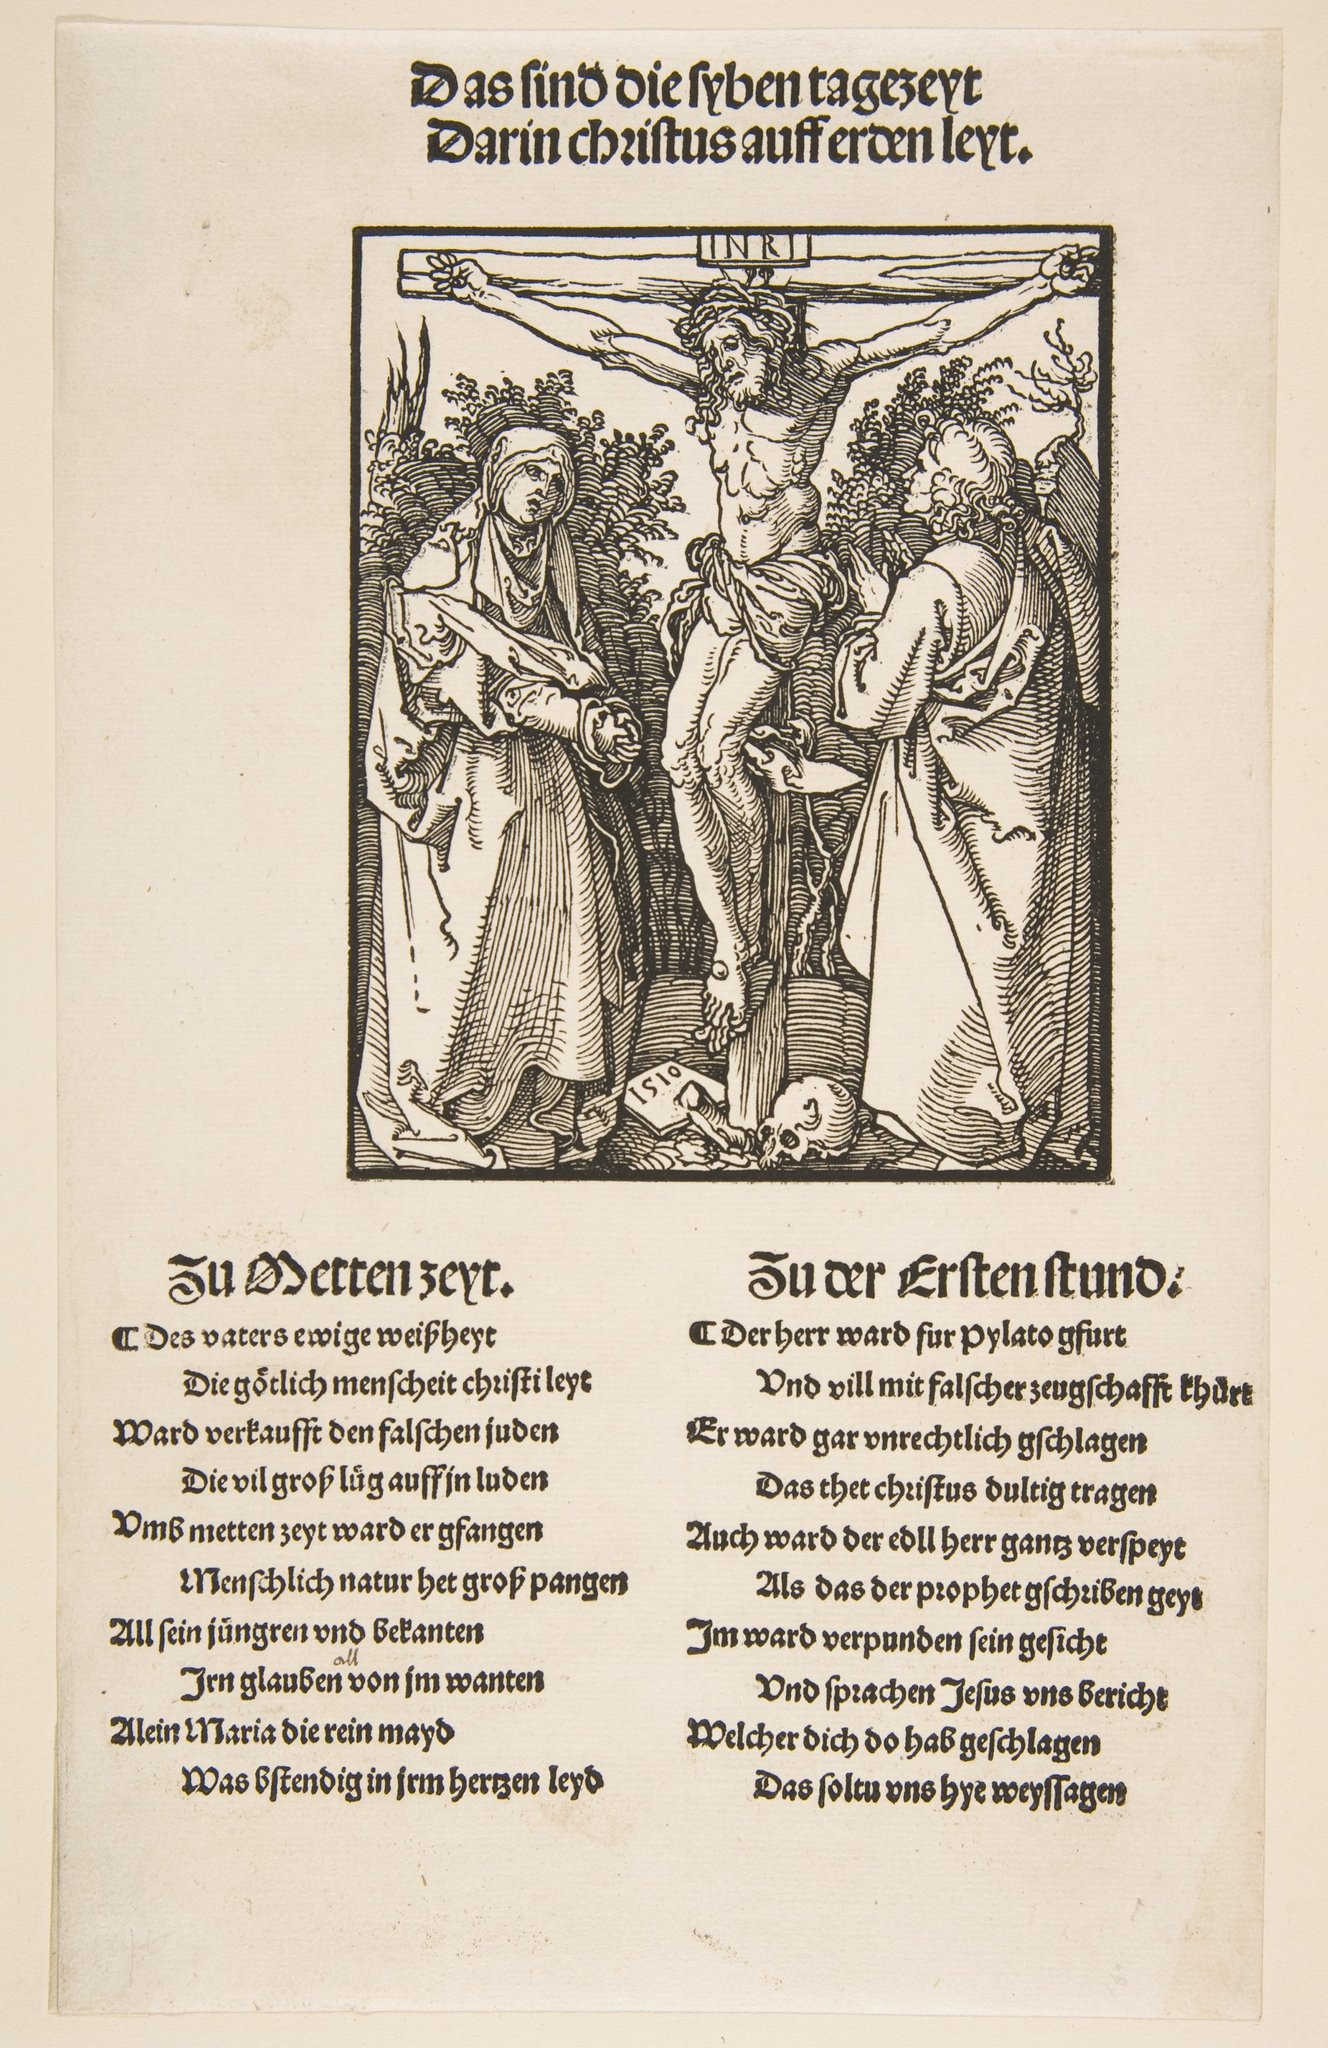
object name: print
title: Christ on the Cross between the Virgin and Saint John (first sheet of two)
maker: albrecht dürer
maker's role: artist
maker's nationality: german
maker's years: 1471-1528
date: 1510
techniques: woodcut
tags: christ,virgin mary,cross,saints